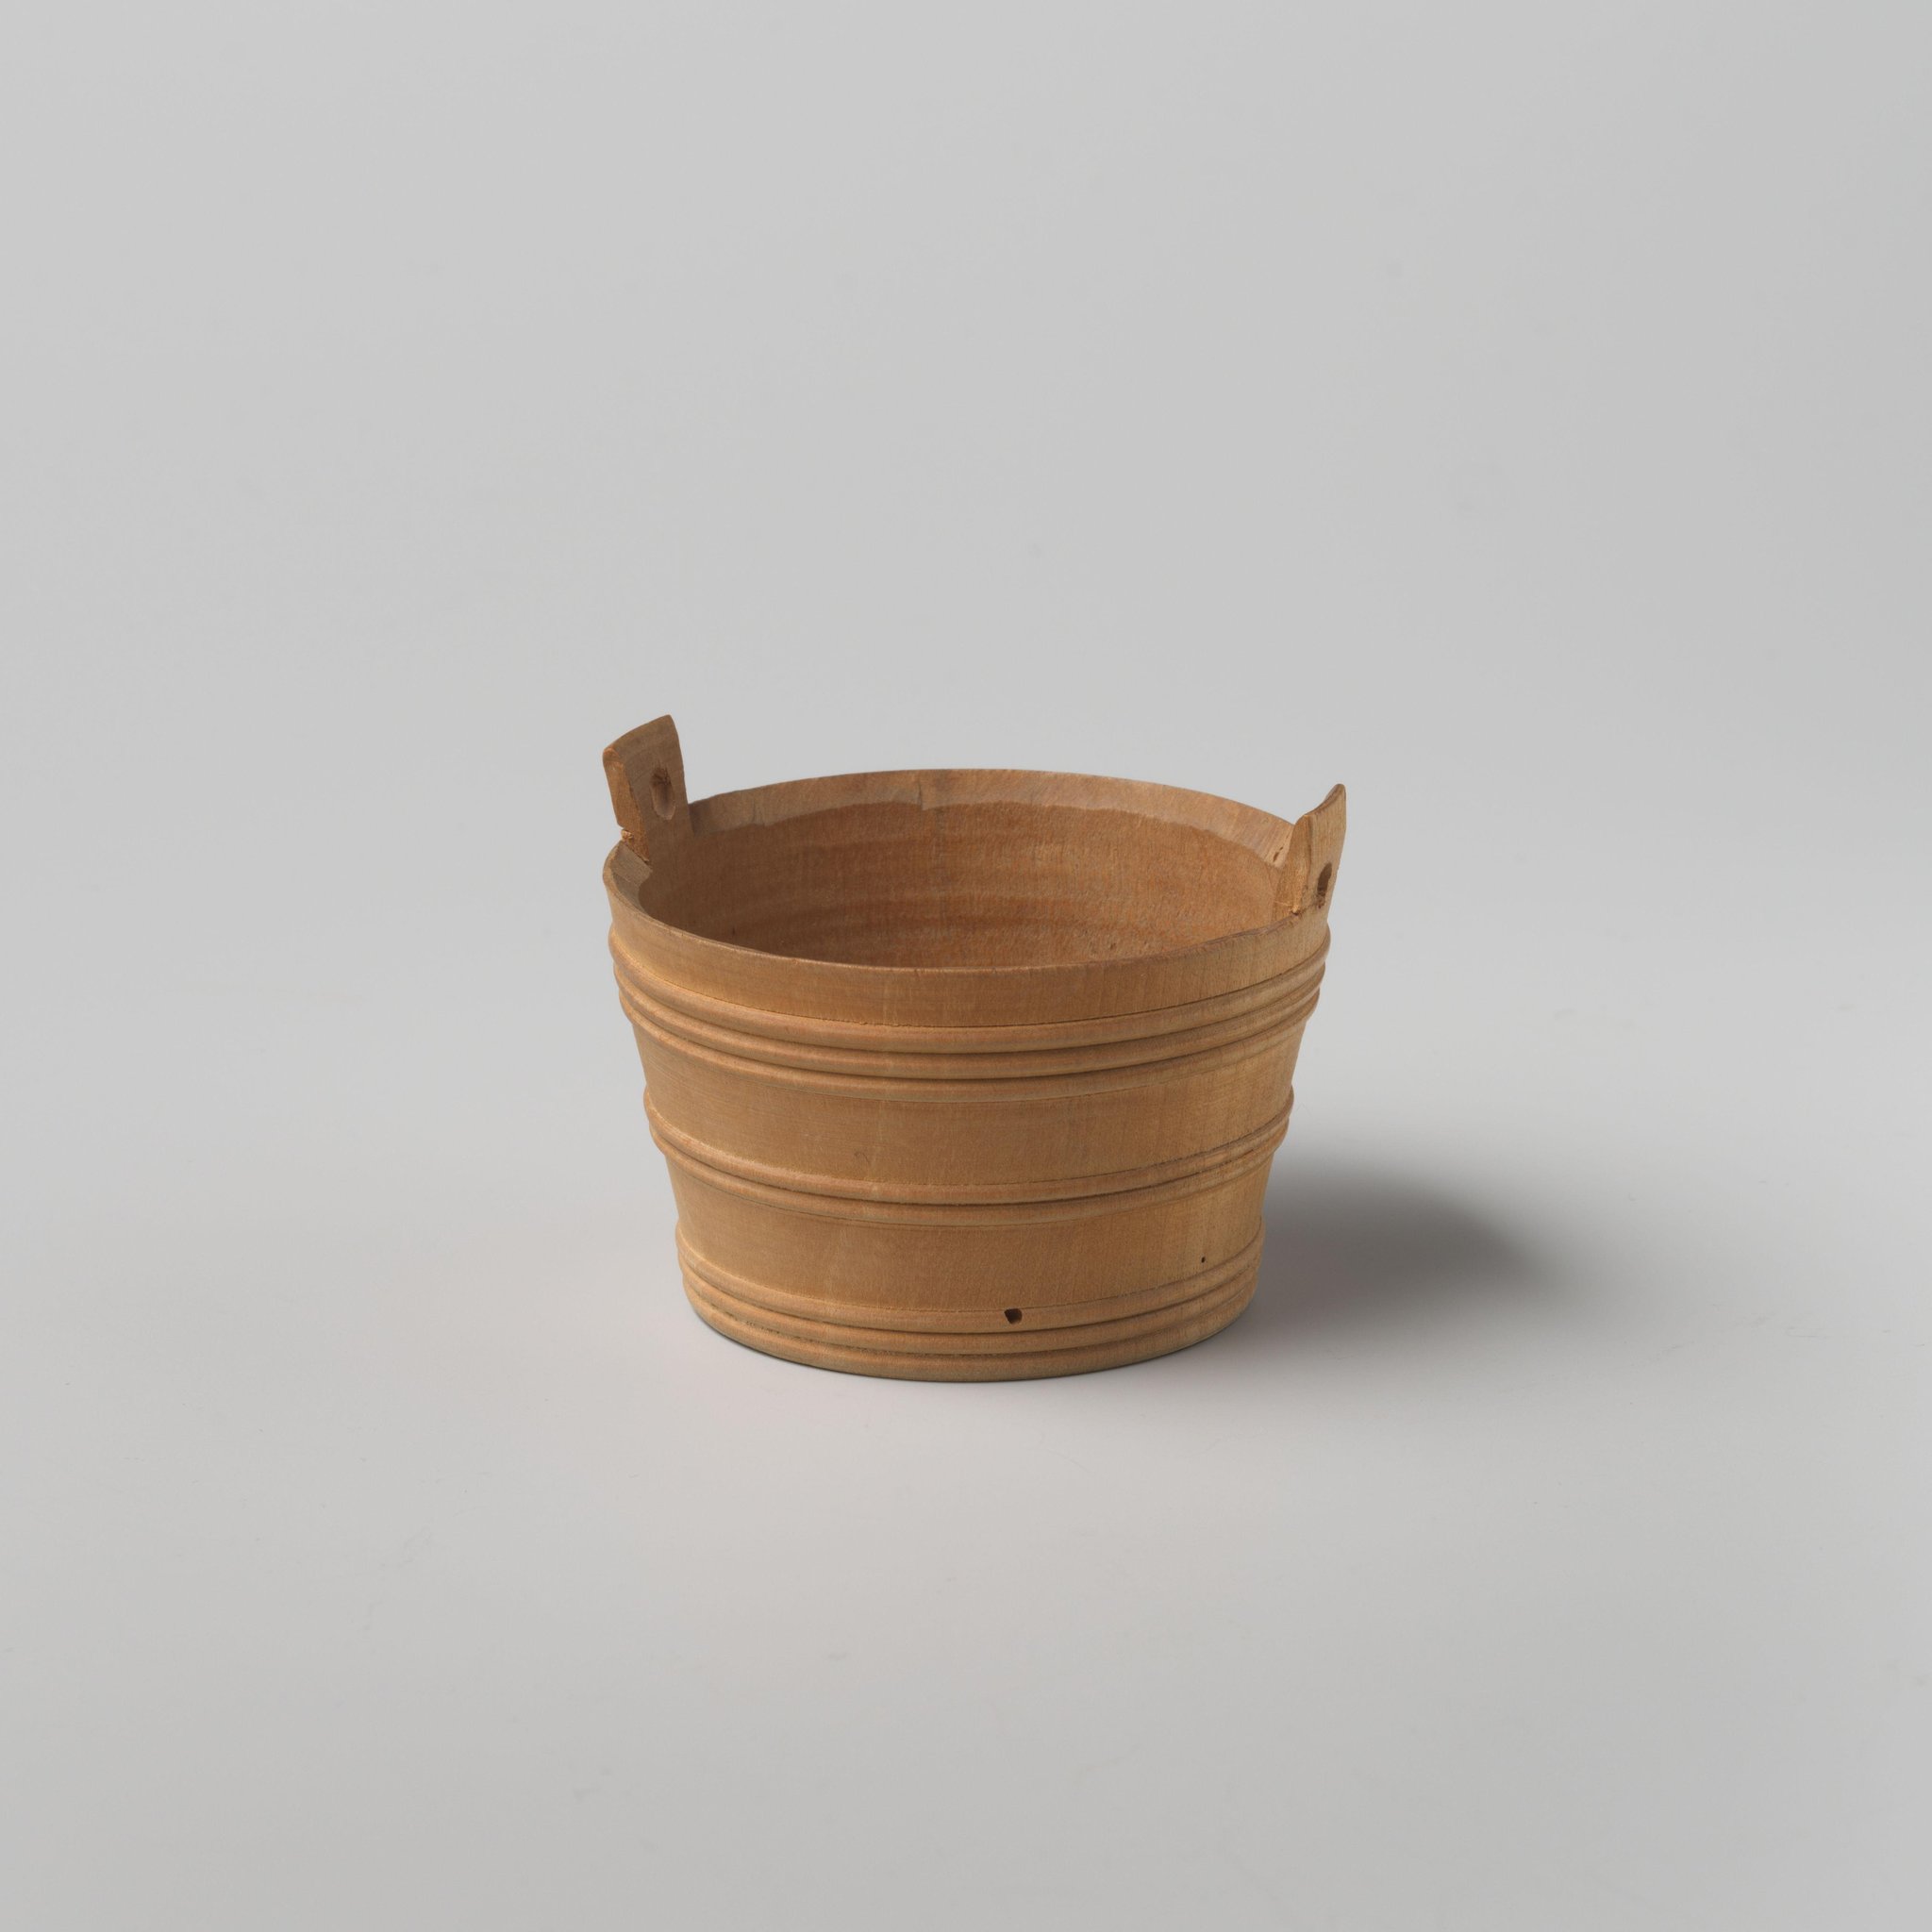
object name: miniature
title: Wastobbe van esdoornhout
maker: Anonymous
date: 1676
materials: wood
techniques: turning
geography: amsterdam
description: Wastobbe, gedraaid van esdoornhout, met ringen (hoepels voorstellende). De tobbe heeft twee rechtopstaande handvatten met een oog.